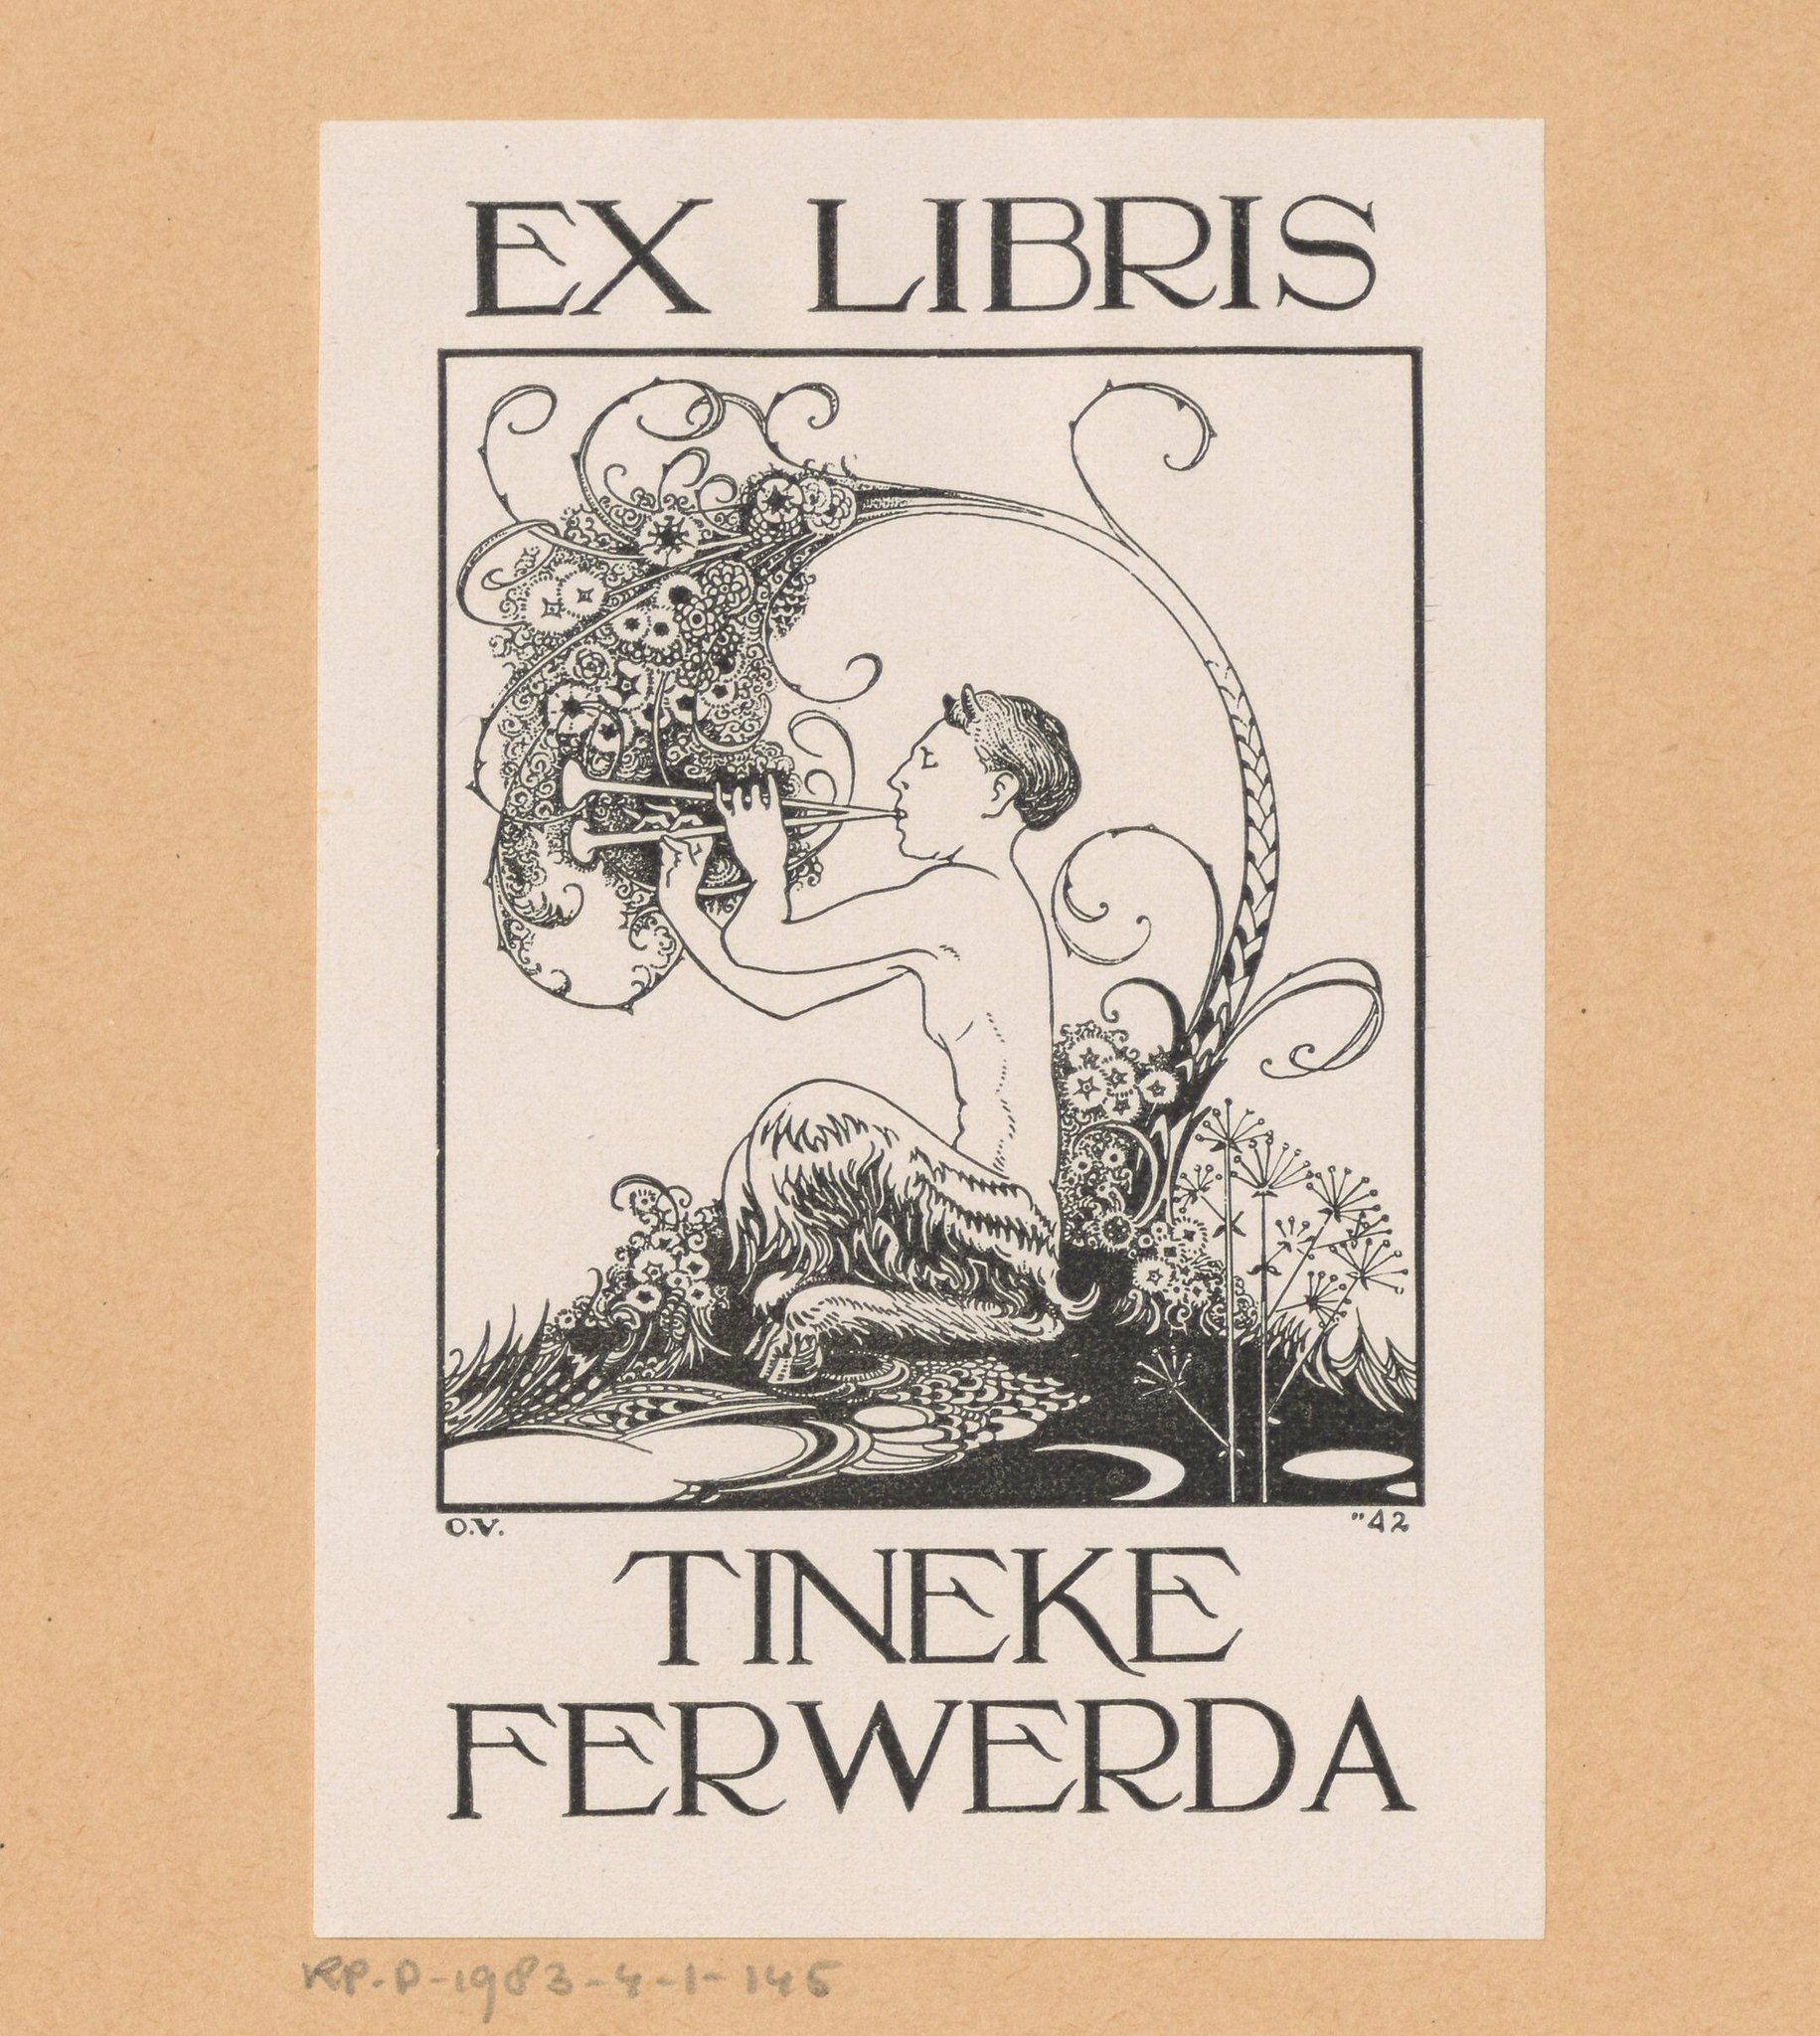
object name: bookplate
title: Ex libris van Tineke Ferwerda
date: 1942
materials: paper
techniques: printing block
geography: netherlands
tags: flowers, sitting figure, satyrs, fauns, sileni, flute, aulos, tibia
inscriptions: inscription: ‘Penteekening/ Clichédruk 1942 (...) hobo en klarinet.’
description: Afbeelding verwijst naar beroep eigenares van het ex libris: klarinetist. De faun blaast op een chalumeau, een voorloper van de klarinet en hobo.